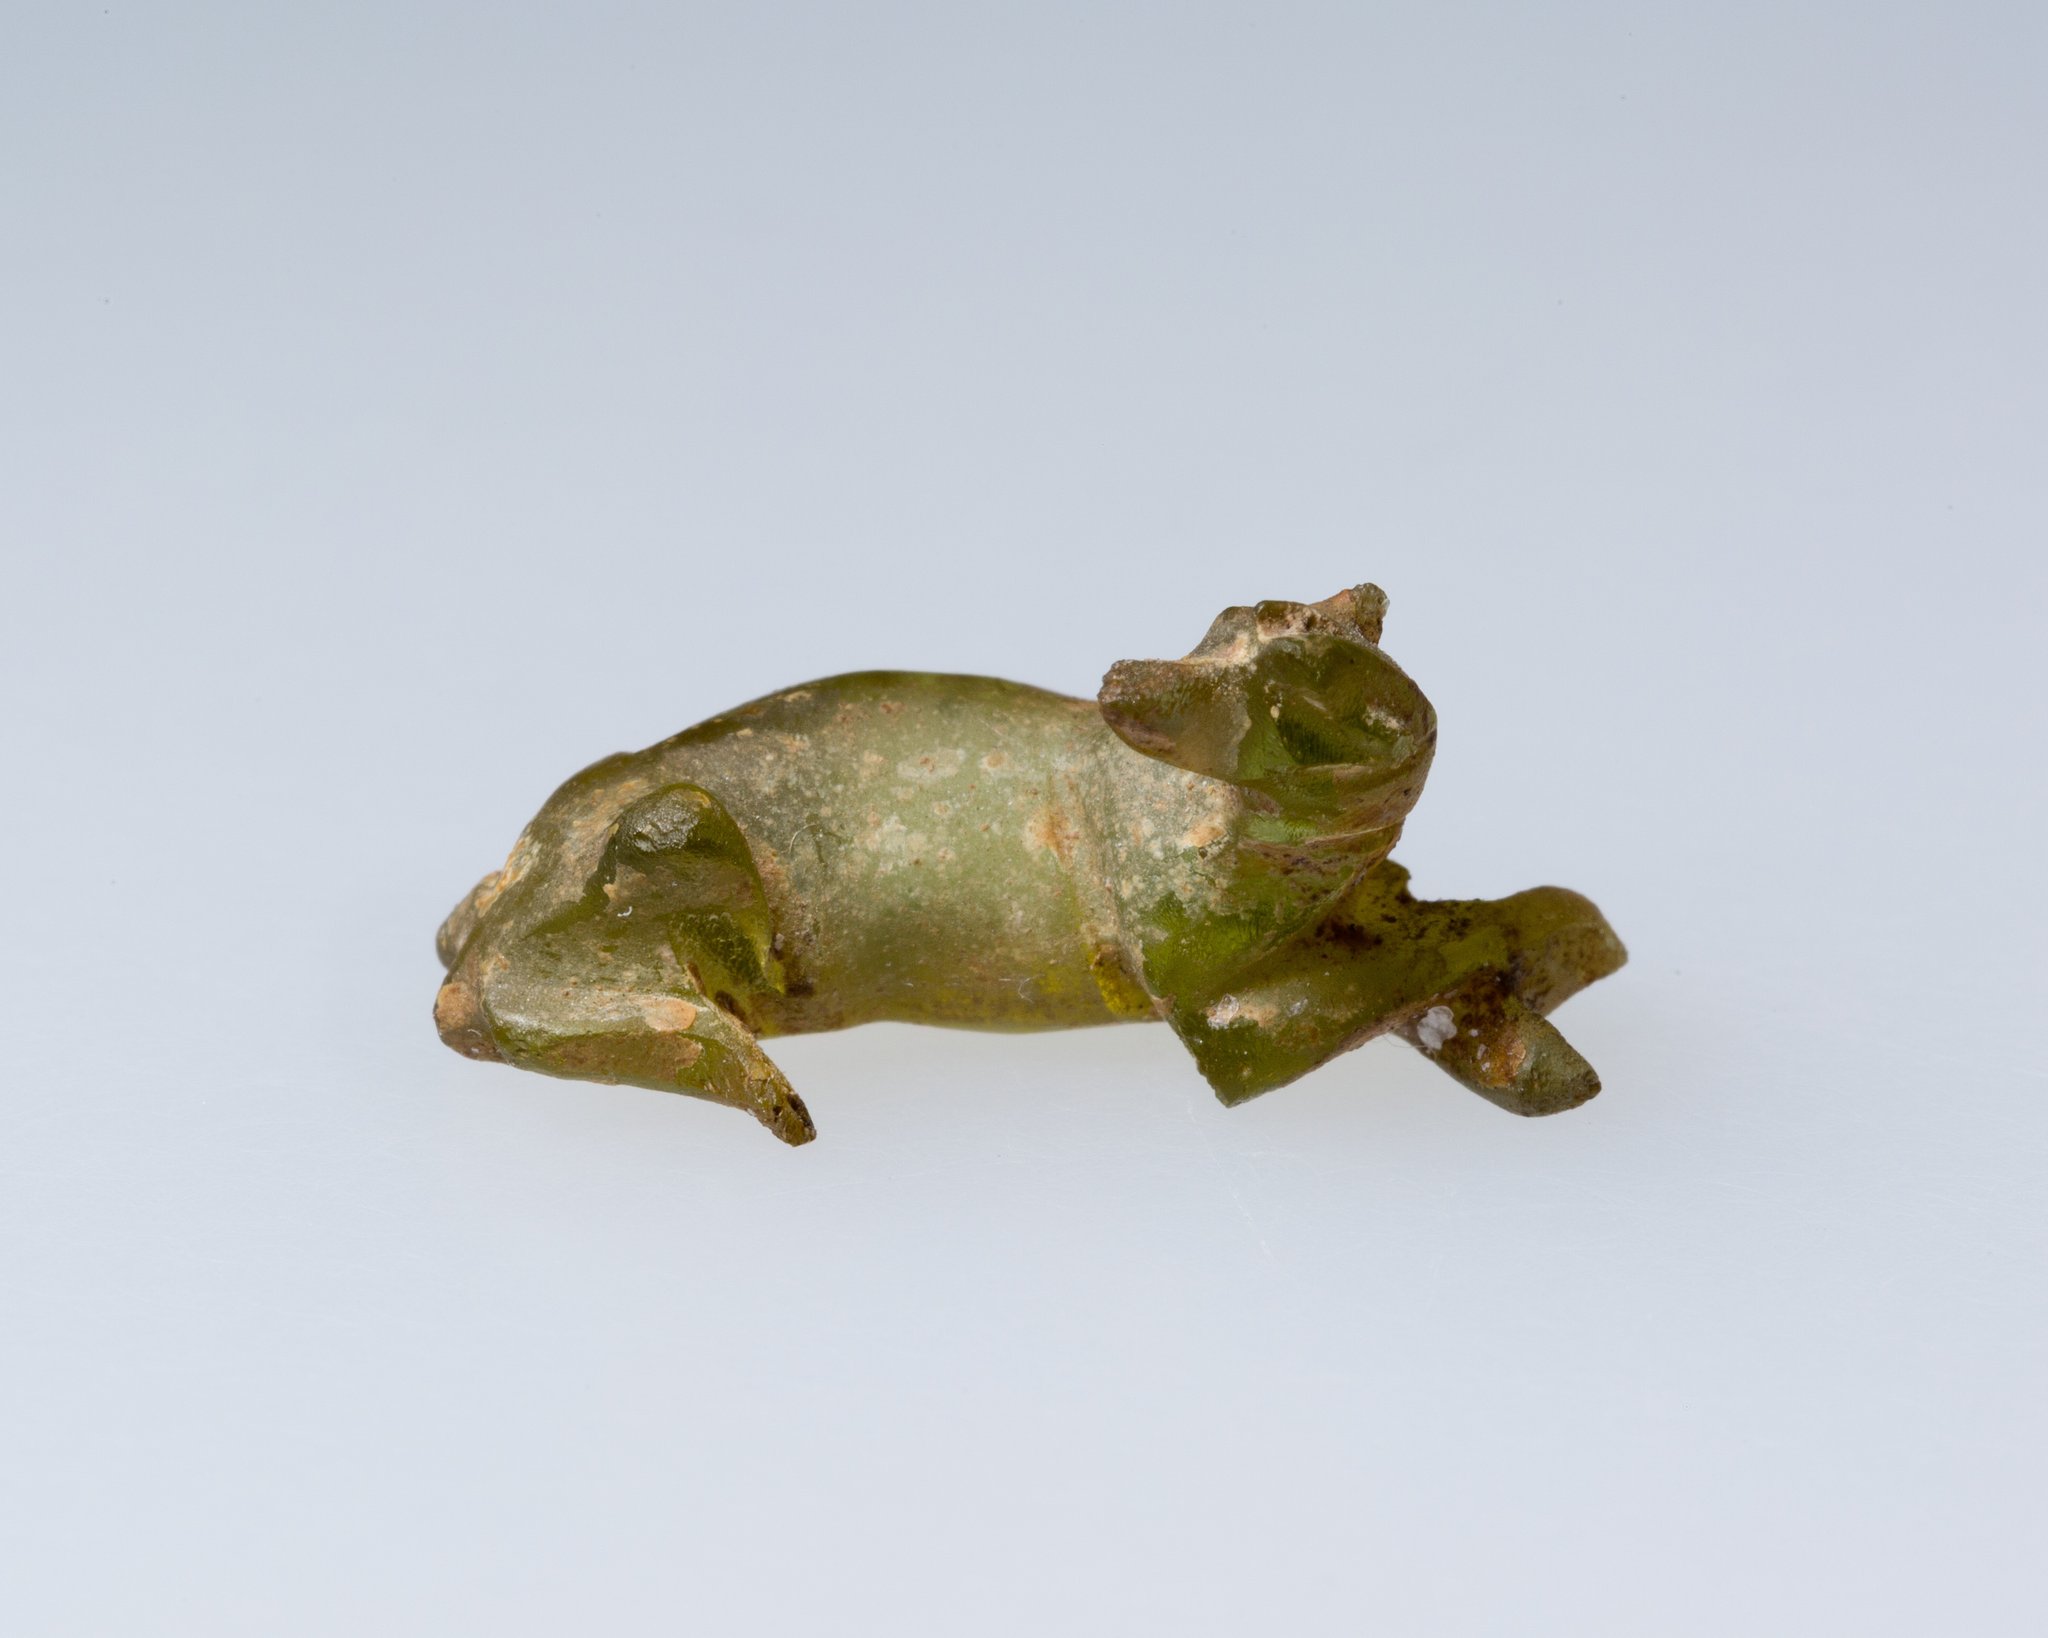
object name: amulet, dog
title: Recumbent dog amulet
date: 200 BCE-200 CE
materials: stone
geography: egypt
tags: dogs